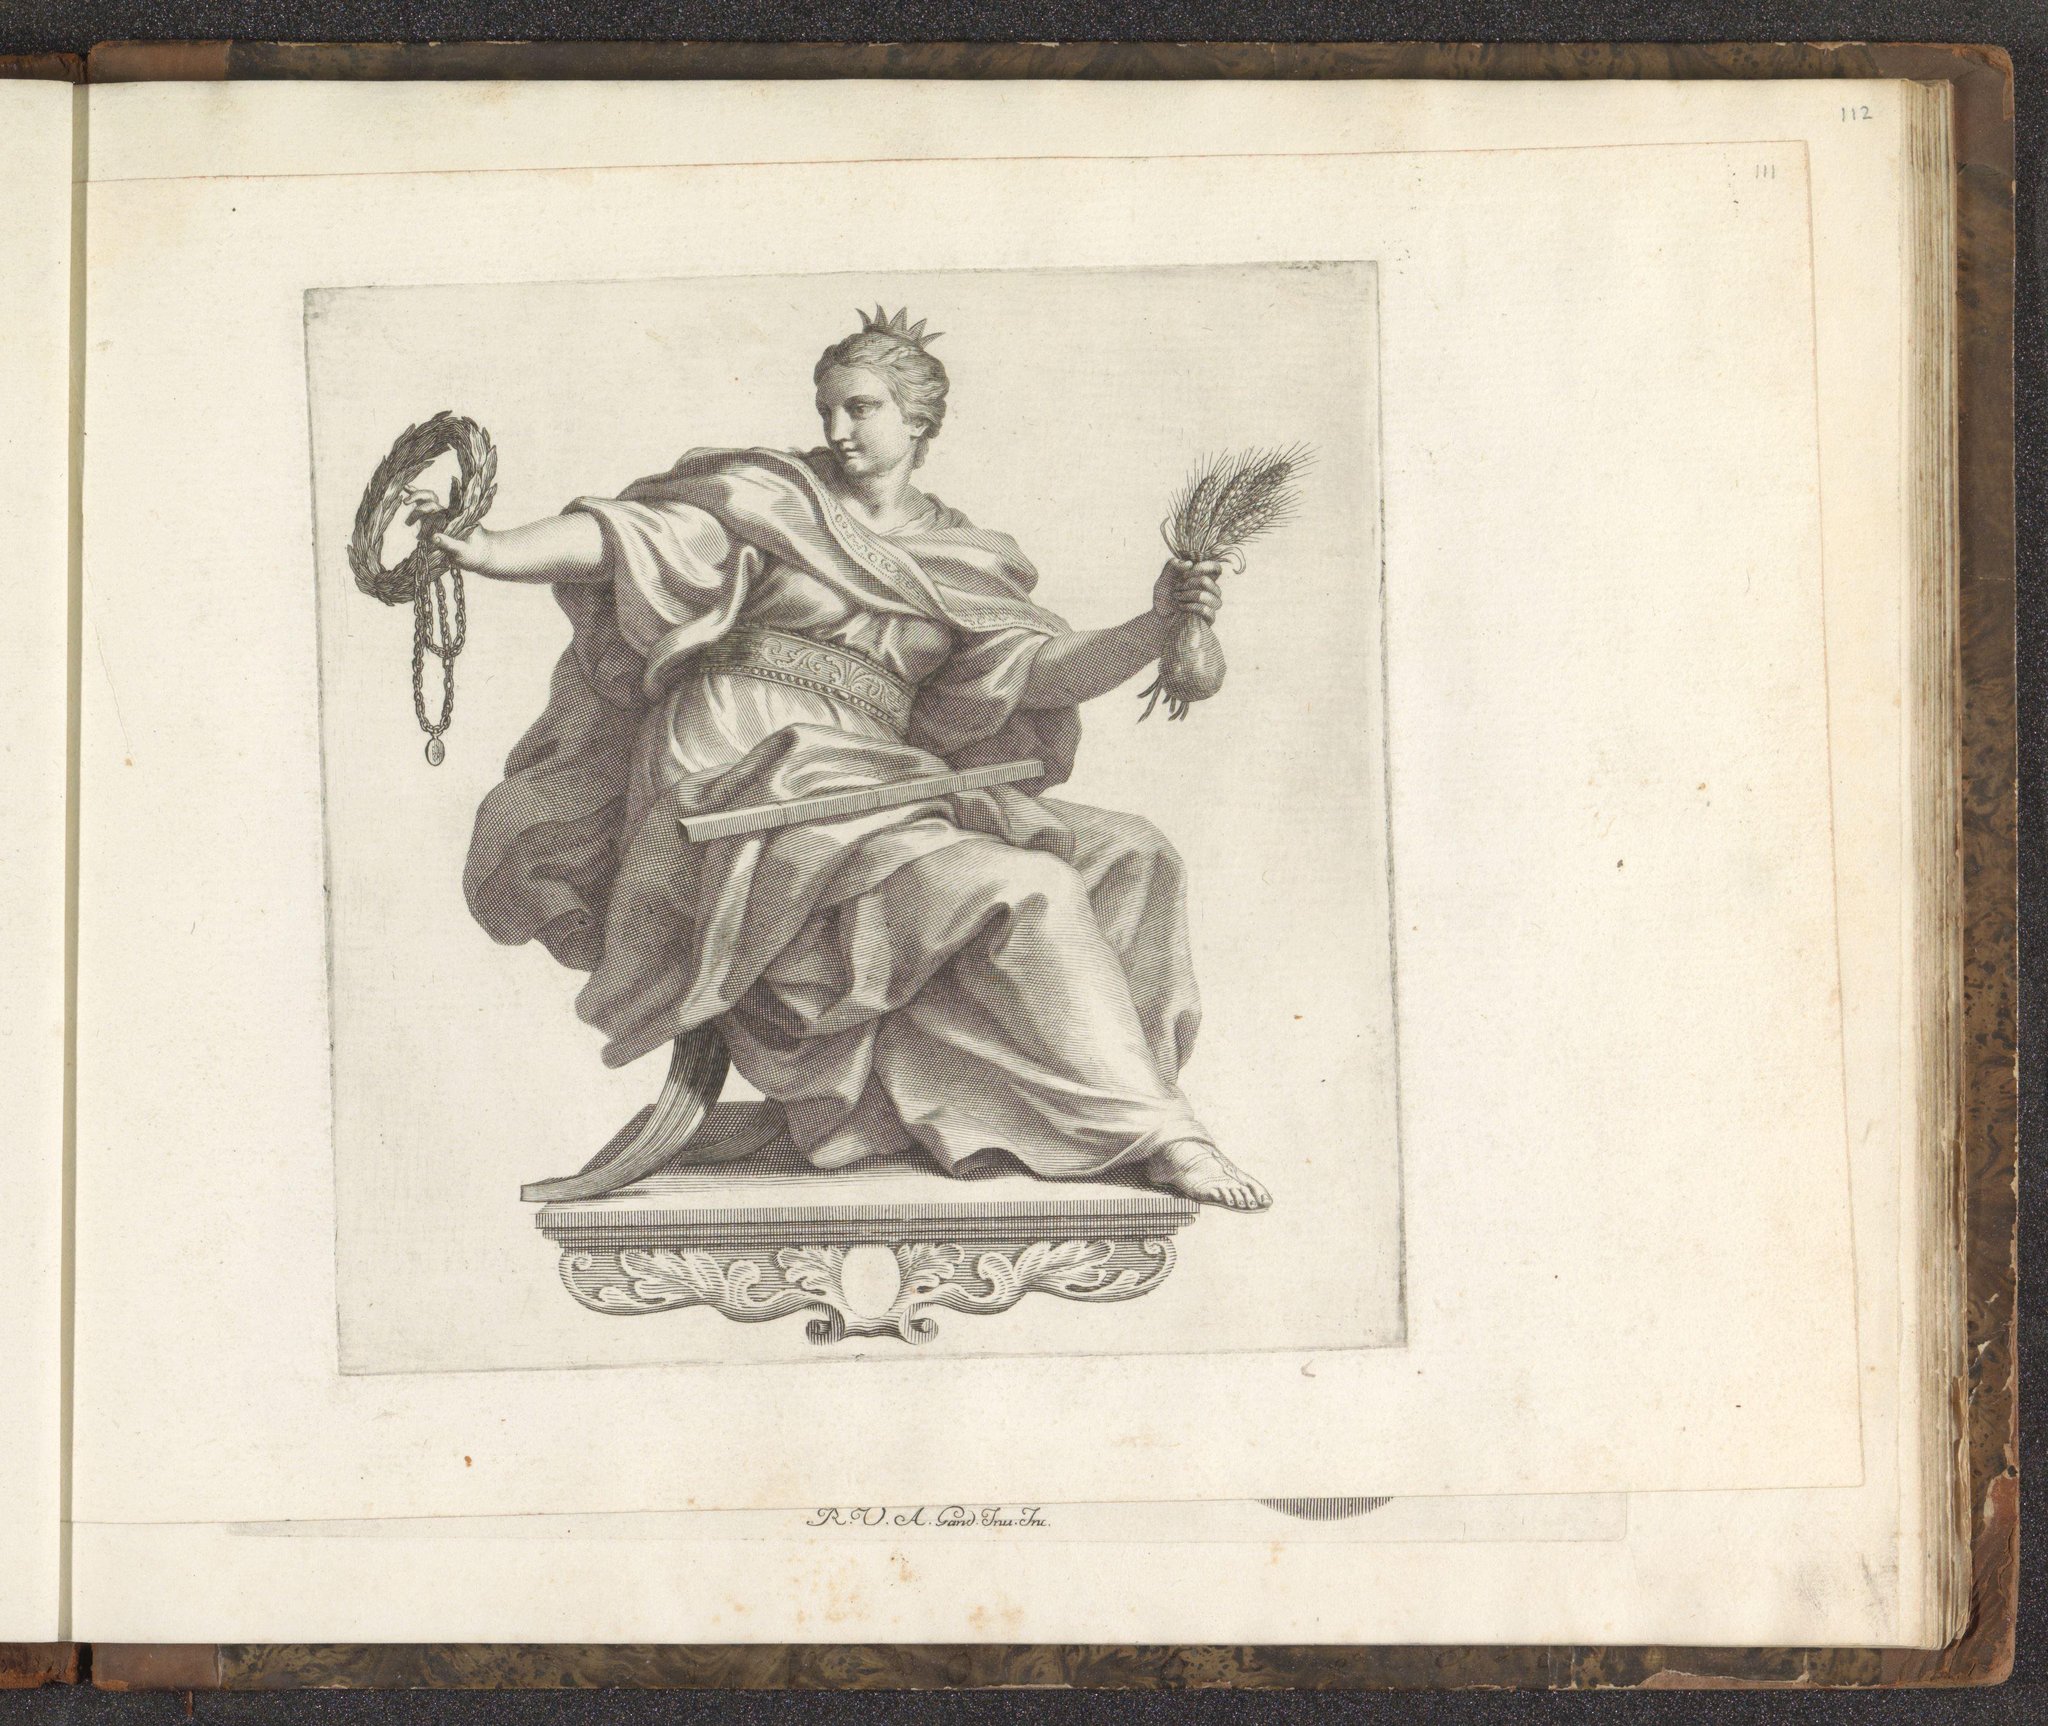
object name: print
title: Numismata virorum illustrium ex Barbadica gente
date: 1673-1743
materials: paper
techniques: engraving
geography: rome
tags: reward, 'praemium'; 'premio', 'remuneratione' (ripa)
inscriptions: collector's mark: Lugt 2228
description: Een console met de vrouwelijke personificatie van Beloning. De vrouw draagt een kroon en heeft een maatstok in haar schoot. In haar rechterhand een lauwerkrans en gouden ketting. In haar linkerhand een bos korenaren en een geldbeurs. De prent maakt deel uit van een album.